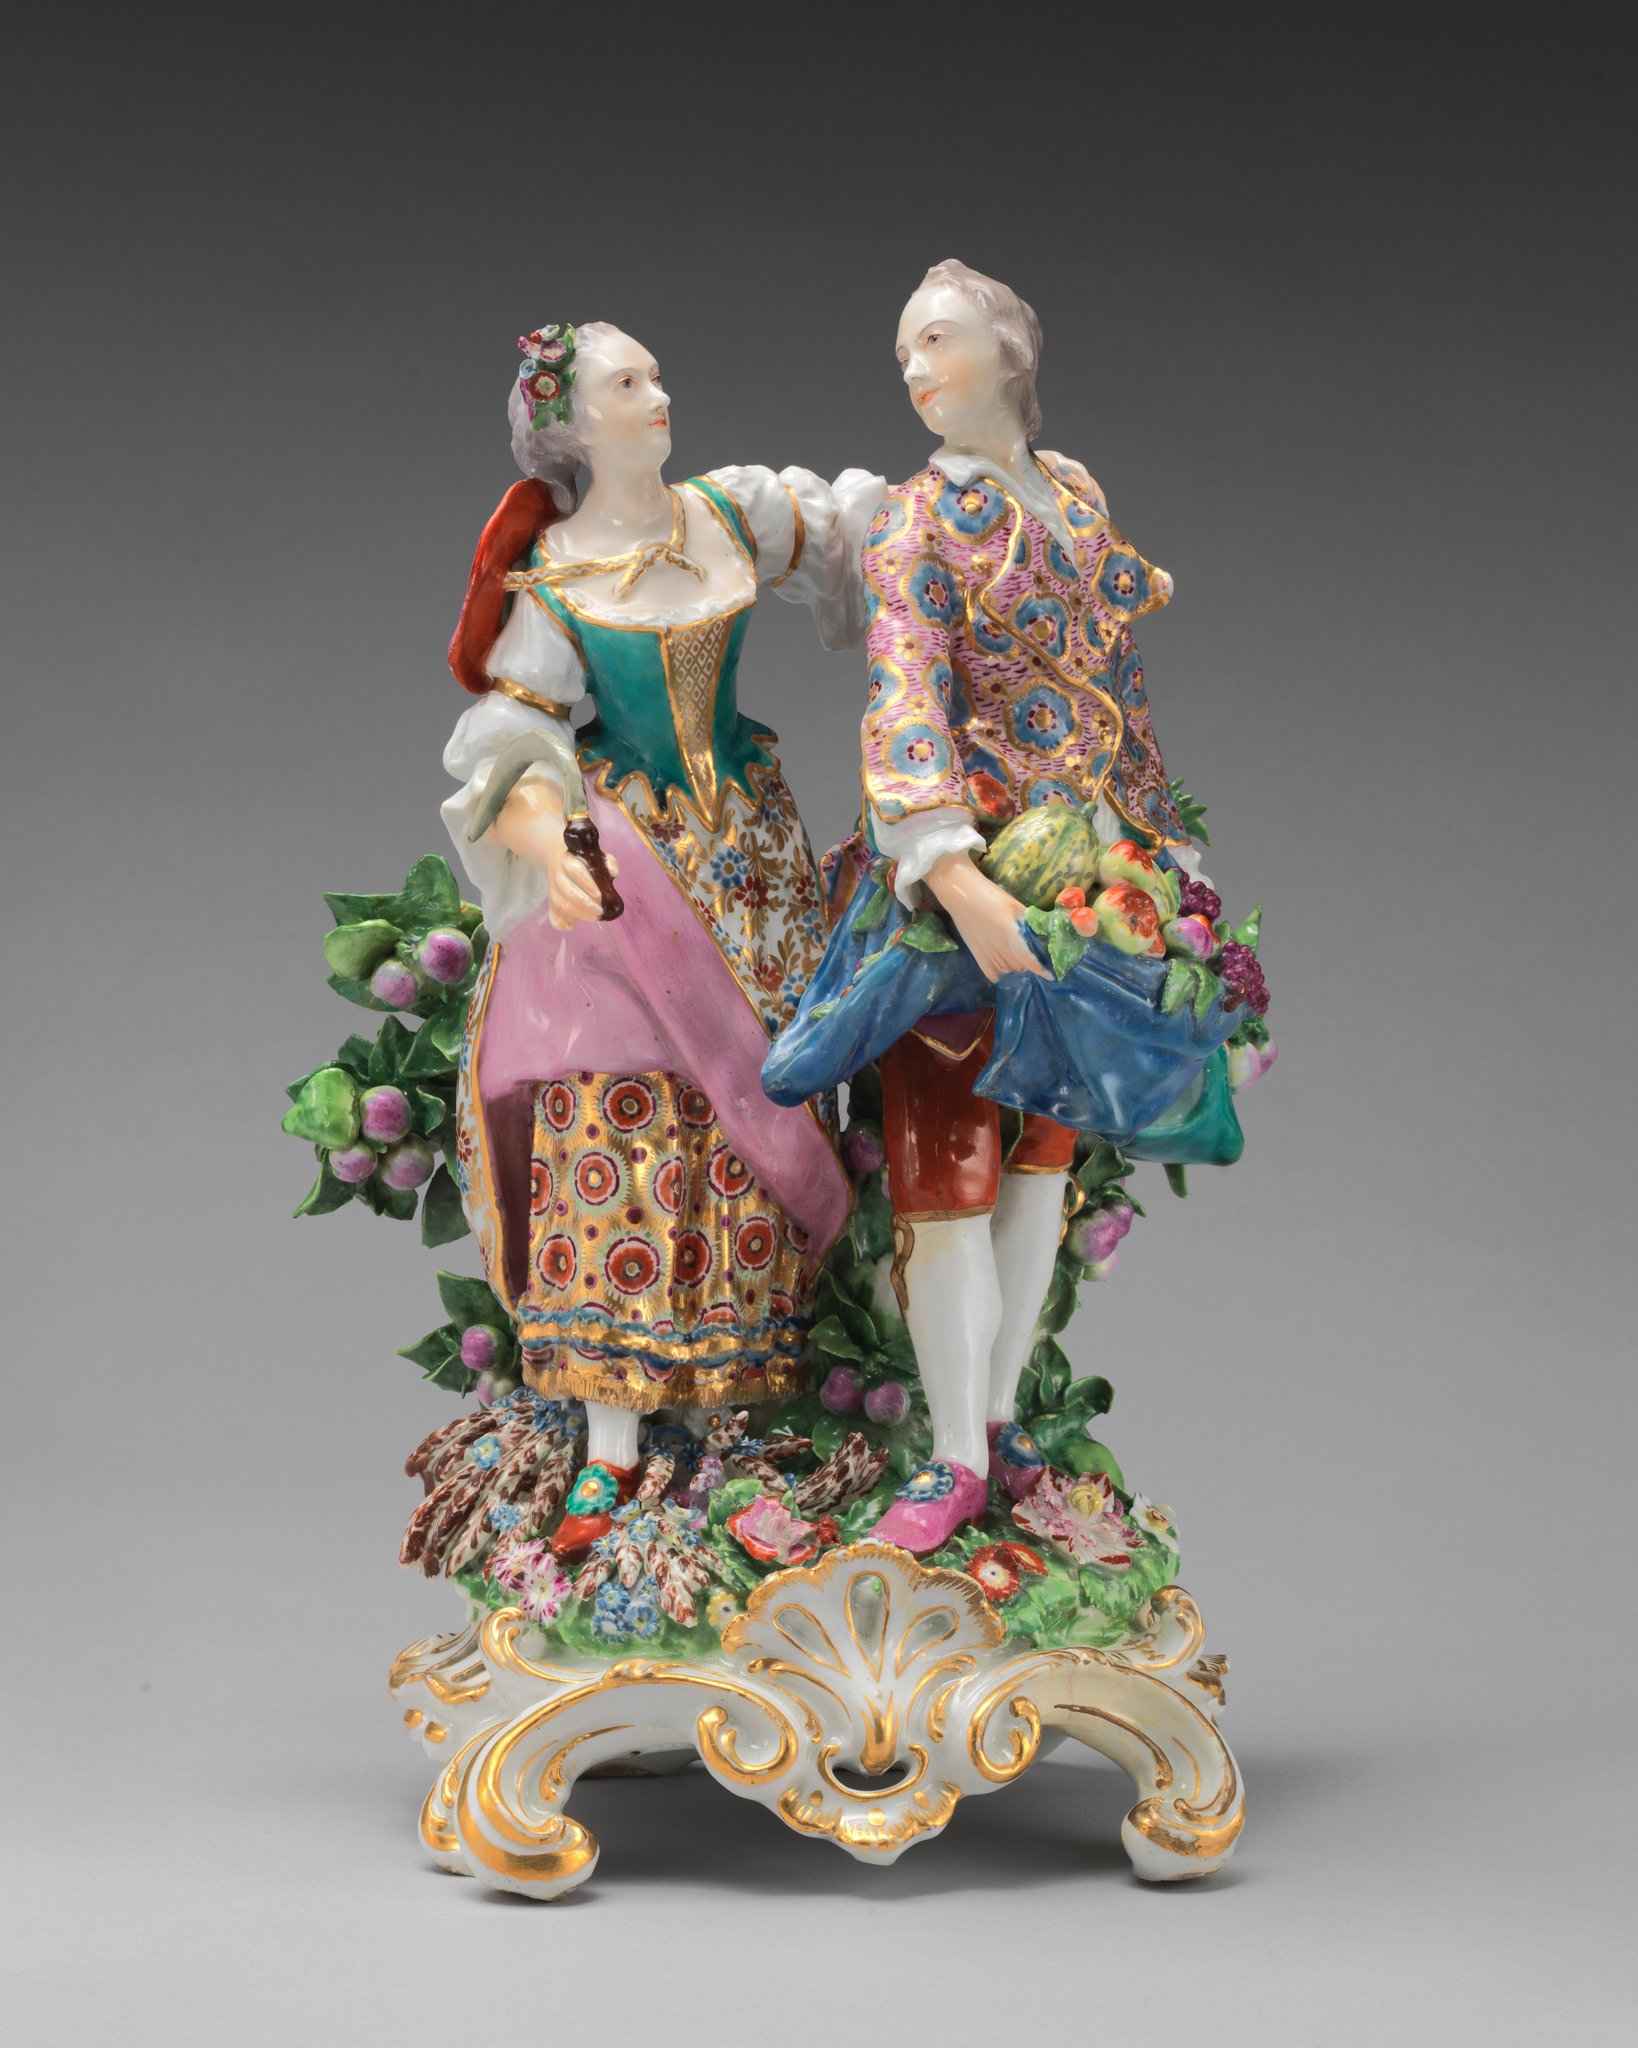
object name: group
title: Summer and Autumn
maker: chelsea porcelain manufactory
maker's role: factory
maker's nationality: british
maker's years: 1744-1784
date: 1765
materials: soft paste porcelain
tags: fruit,women